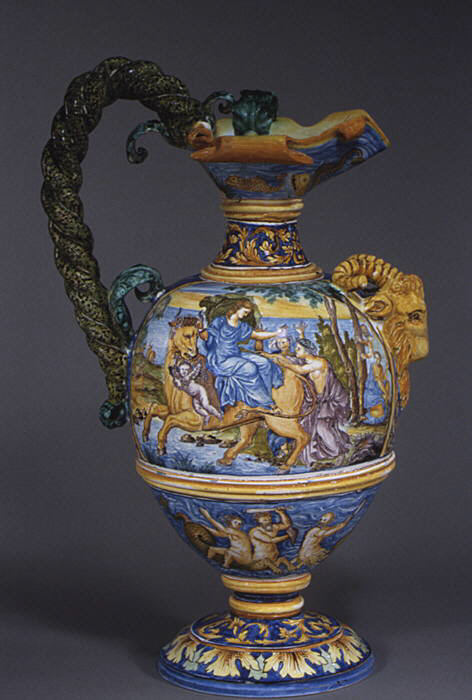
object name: wine jug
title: Wine jug (one of a pair)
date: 1680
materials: faience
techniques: glazing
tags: women,horses